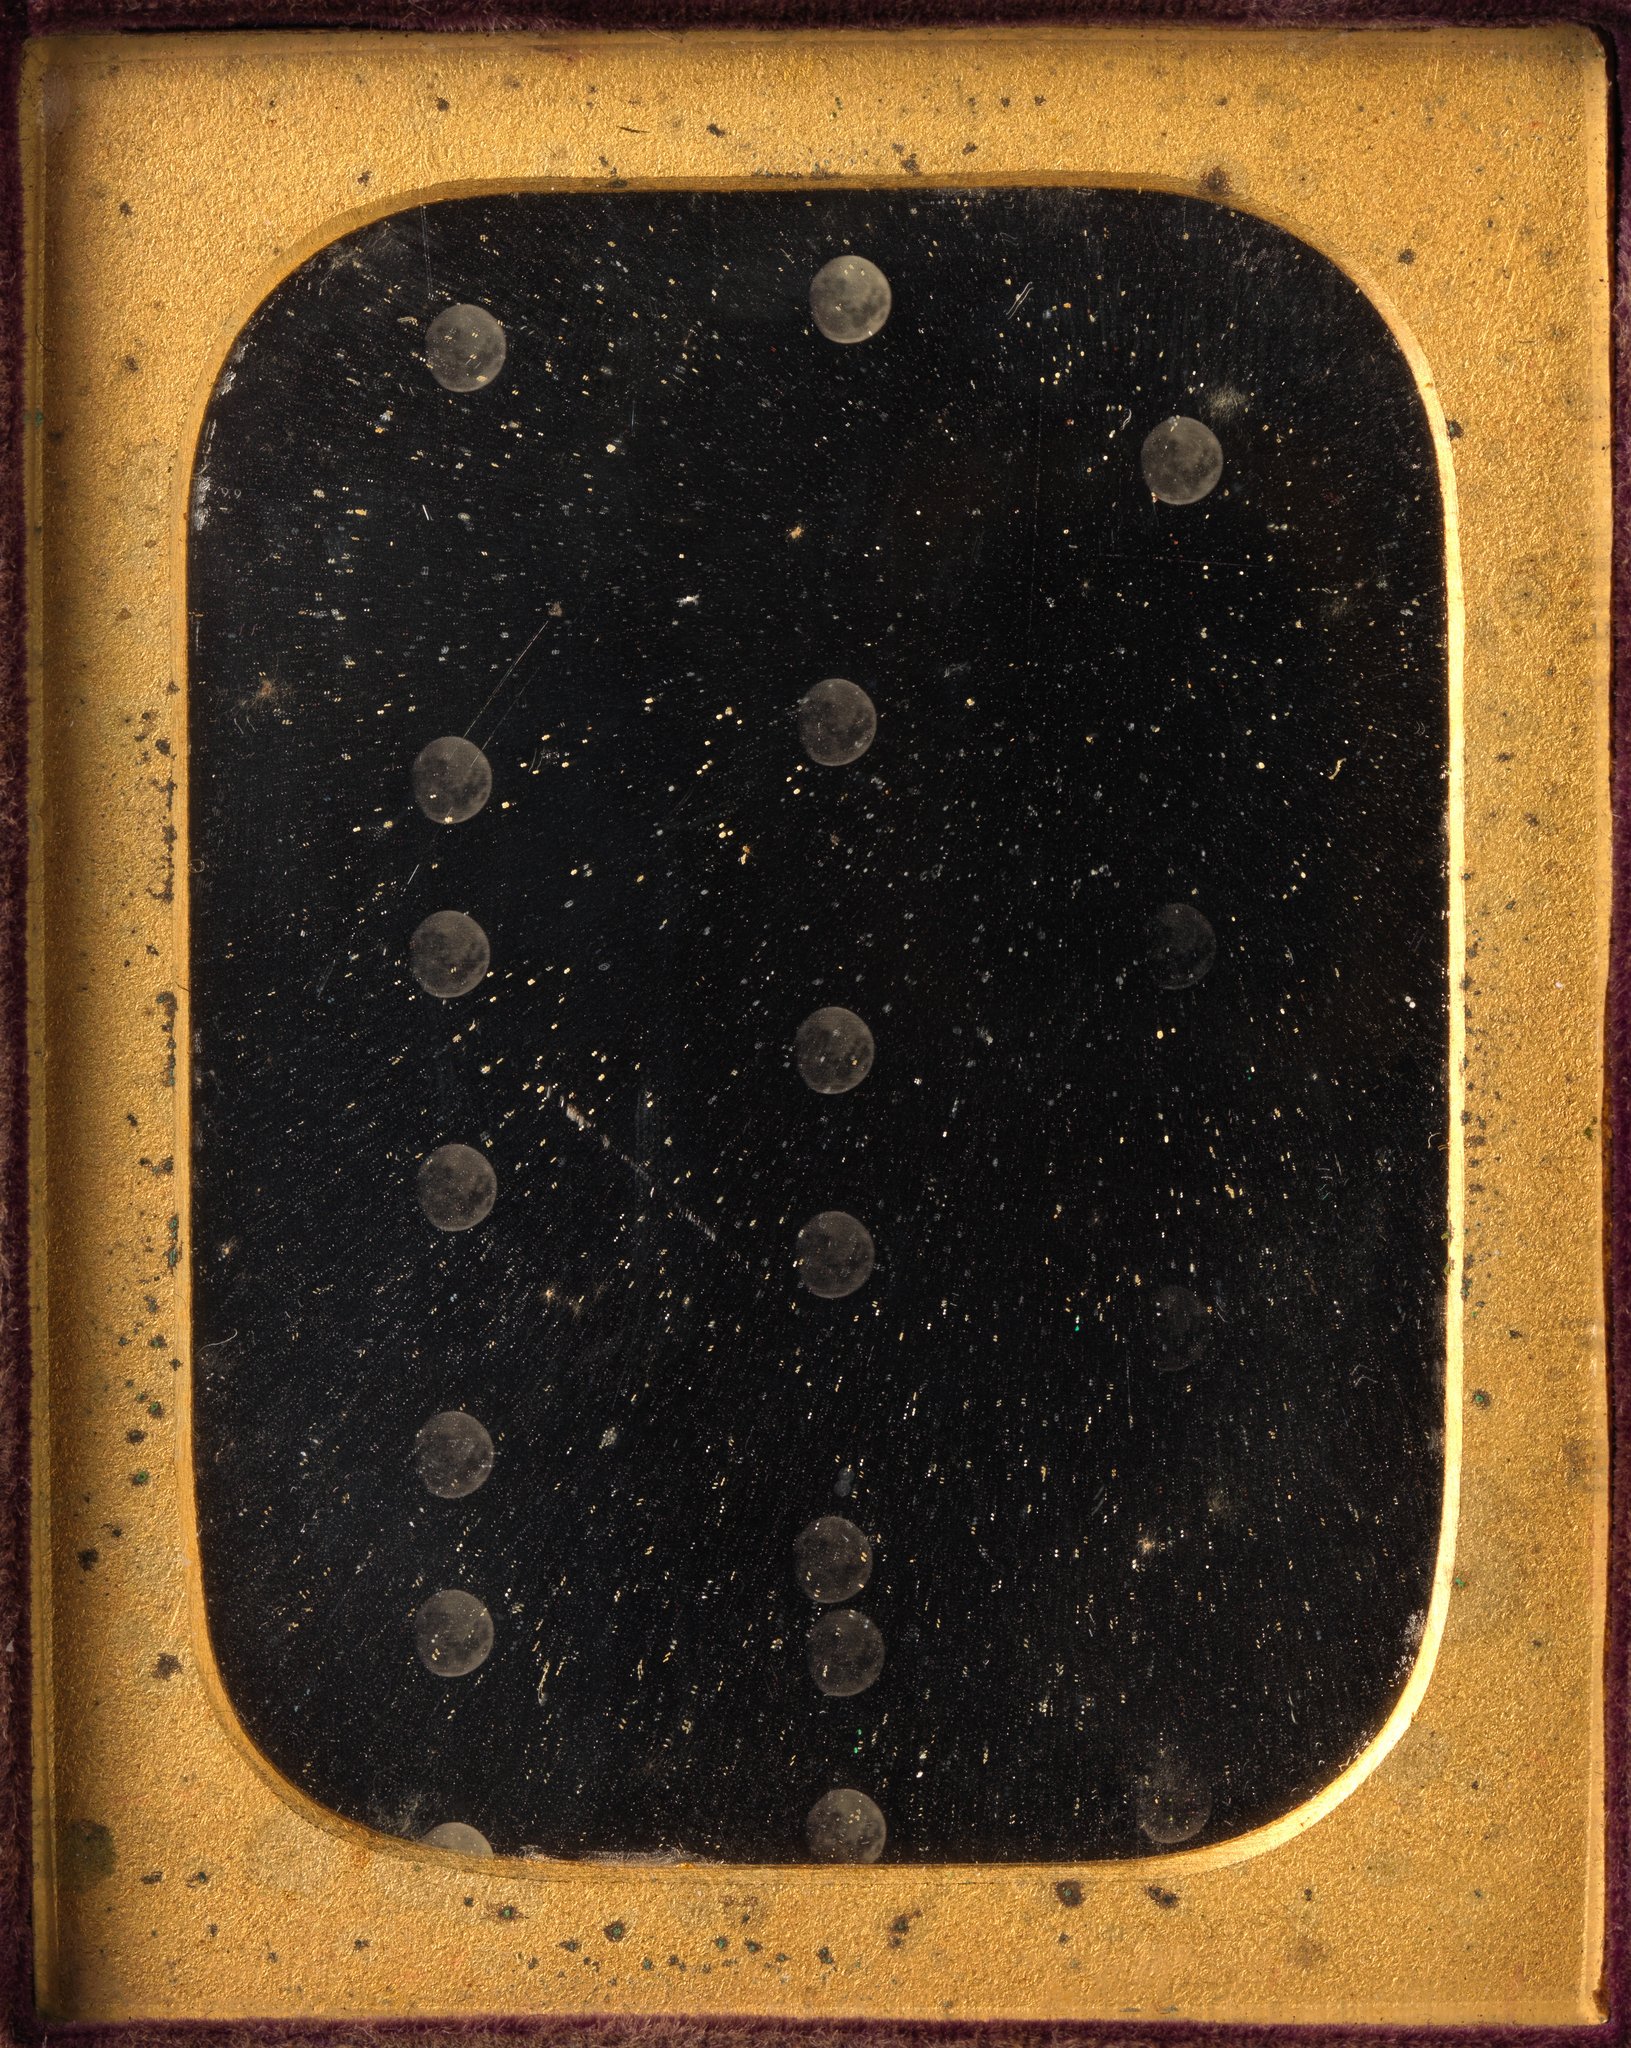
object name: daguerreotype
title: [Multiple Exposures of the Moon]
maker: antoine-françois-jean claudet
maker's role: artist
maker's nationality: french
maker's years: 1797-1867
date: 1846-1852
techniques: daguerreotype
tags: moon,astronomy